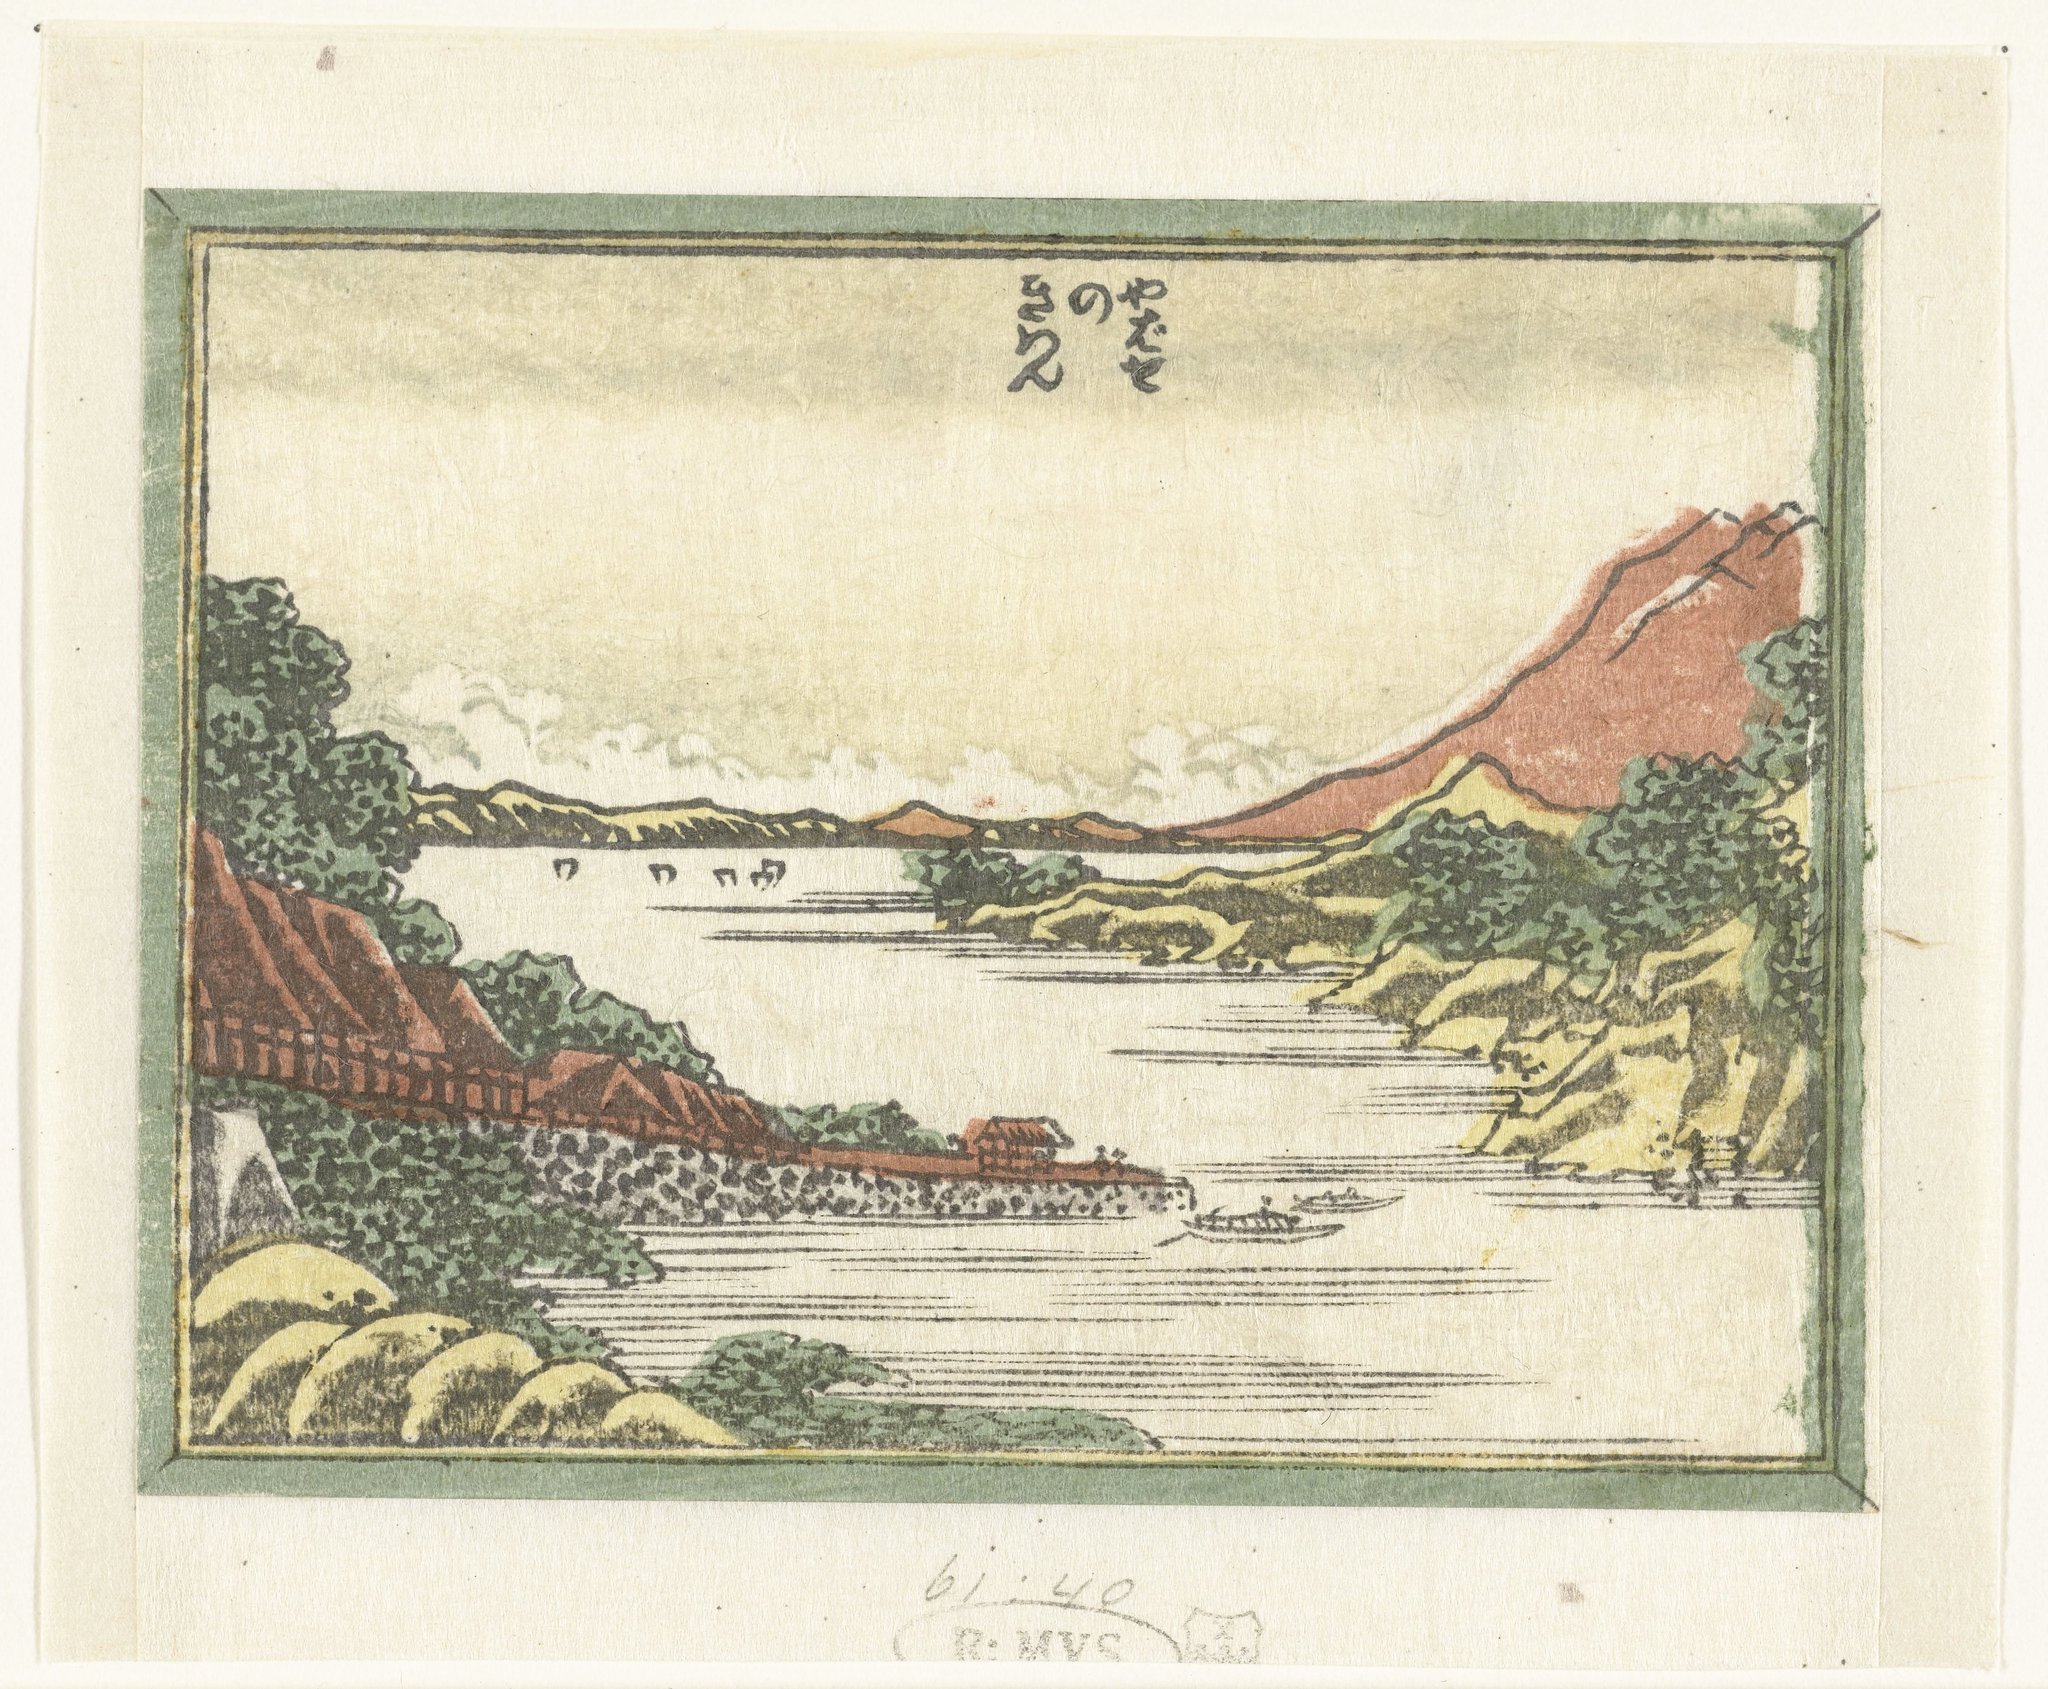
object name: print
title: Doban Omi hakkei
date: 1809-1814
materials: paper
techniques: blind stamped, woodcut, nishiki e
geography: japan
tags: rowing-boat, canoe, etc., lake, mountains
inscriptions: collector's mark: Lugt 2760, collector's mark: Lugt 2228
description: Berglandschap met meer waarop twee roeibootjes en in de verte zeilschepen.